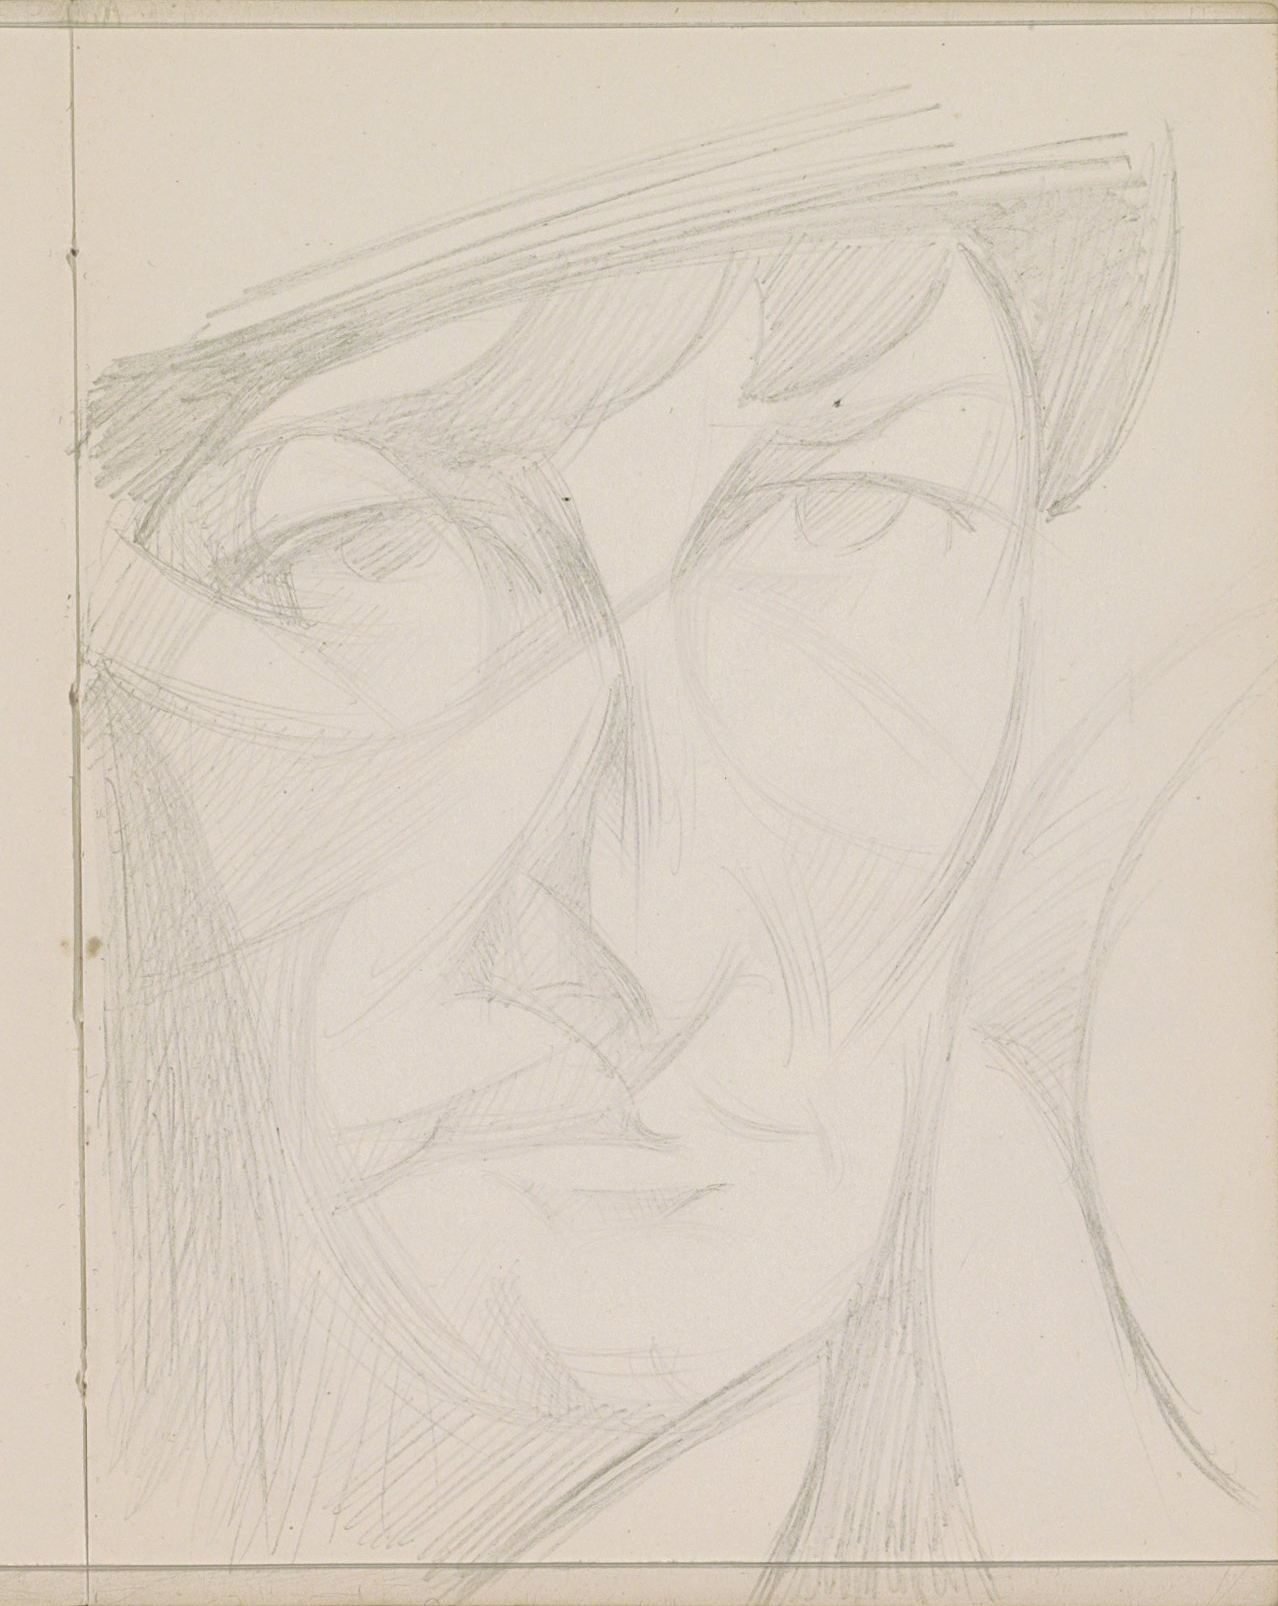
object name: sketchbook leaf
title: Hoofd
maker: reijer stolk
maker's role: draughtsman, print maker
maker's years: 1896-1945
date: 1916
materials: paper, pencil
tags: head (human)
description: Blad 66 recto uit een schetsboek met 72 bladen.